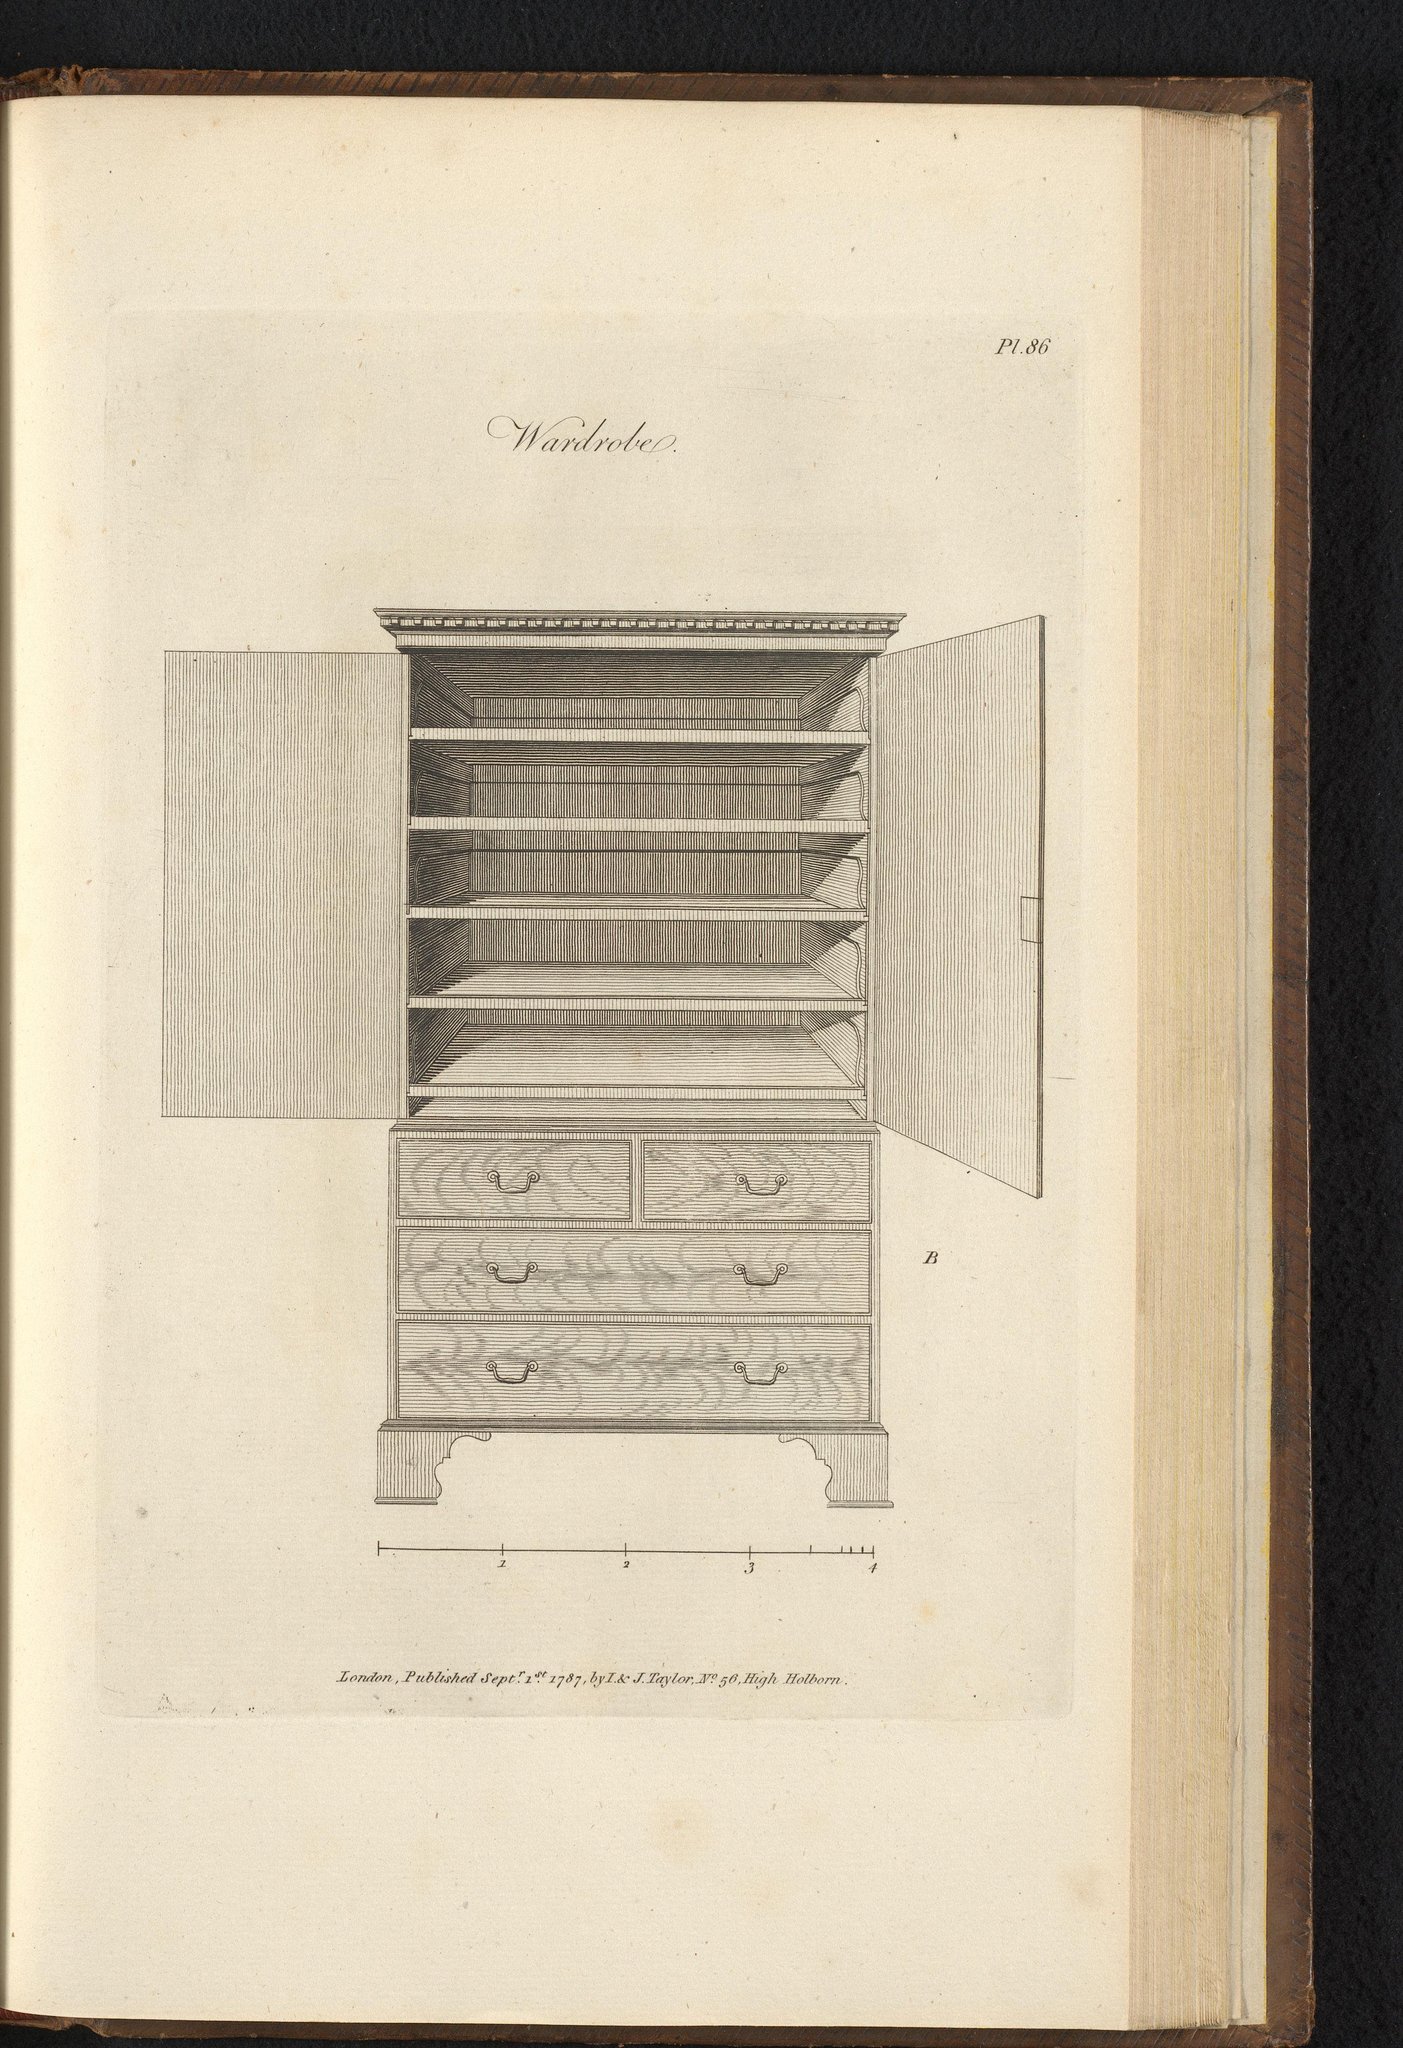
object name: print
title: Wardrobe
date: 1787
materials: paper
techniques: engraving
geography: holborn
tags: wardrobe, linen-closet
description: Genummerd: Pl. 86. Kast gemerkt als: B. Schaalverdeling in de ondermarge. Prent maakt deel uit van een boek.